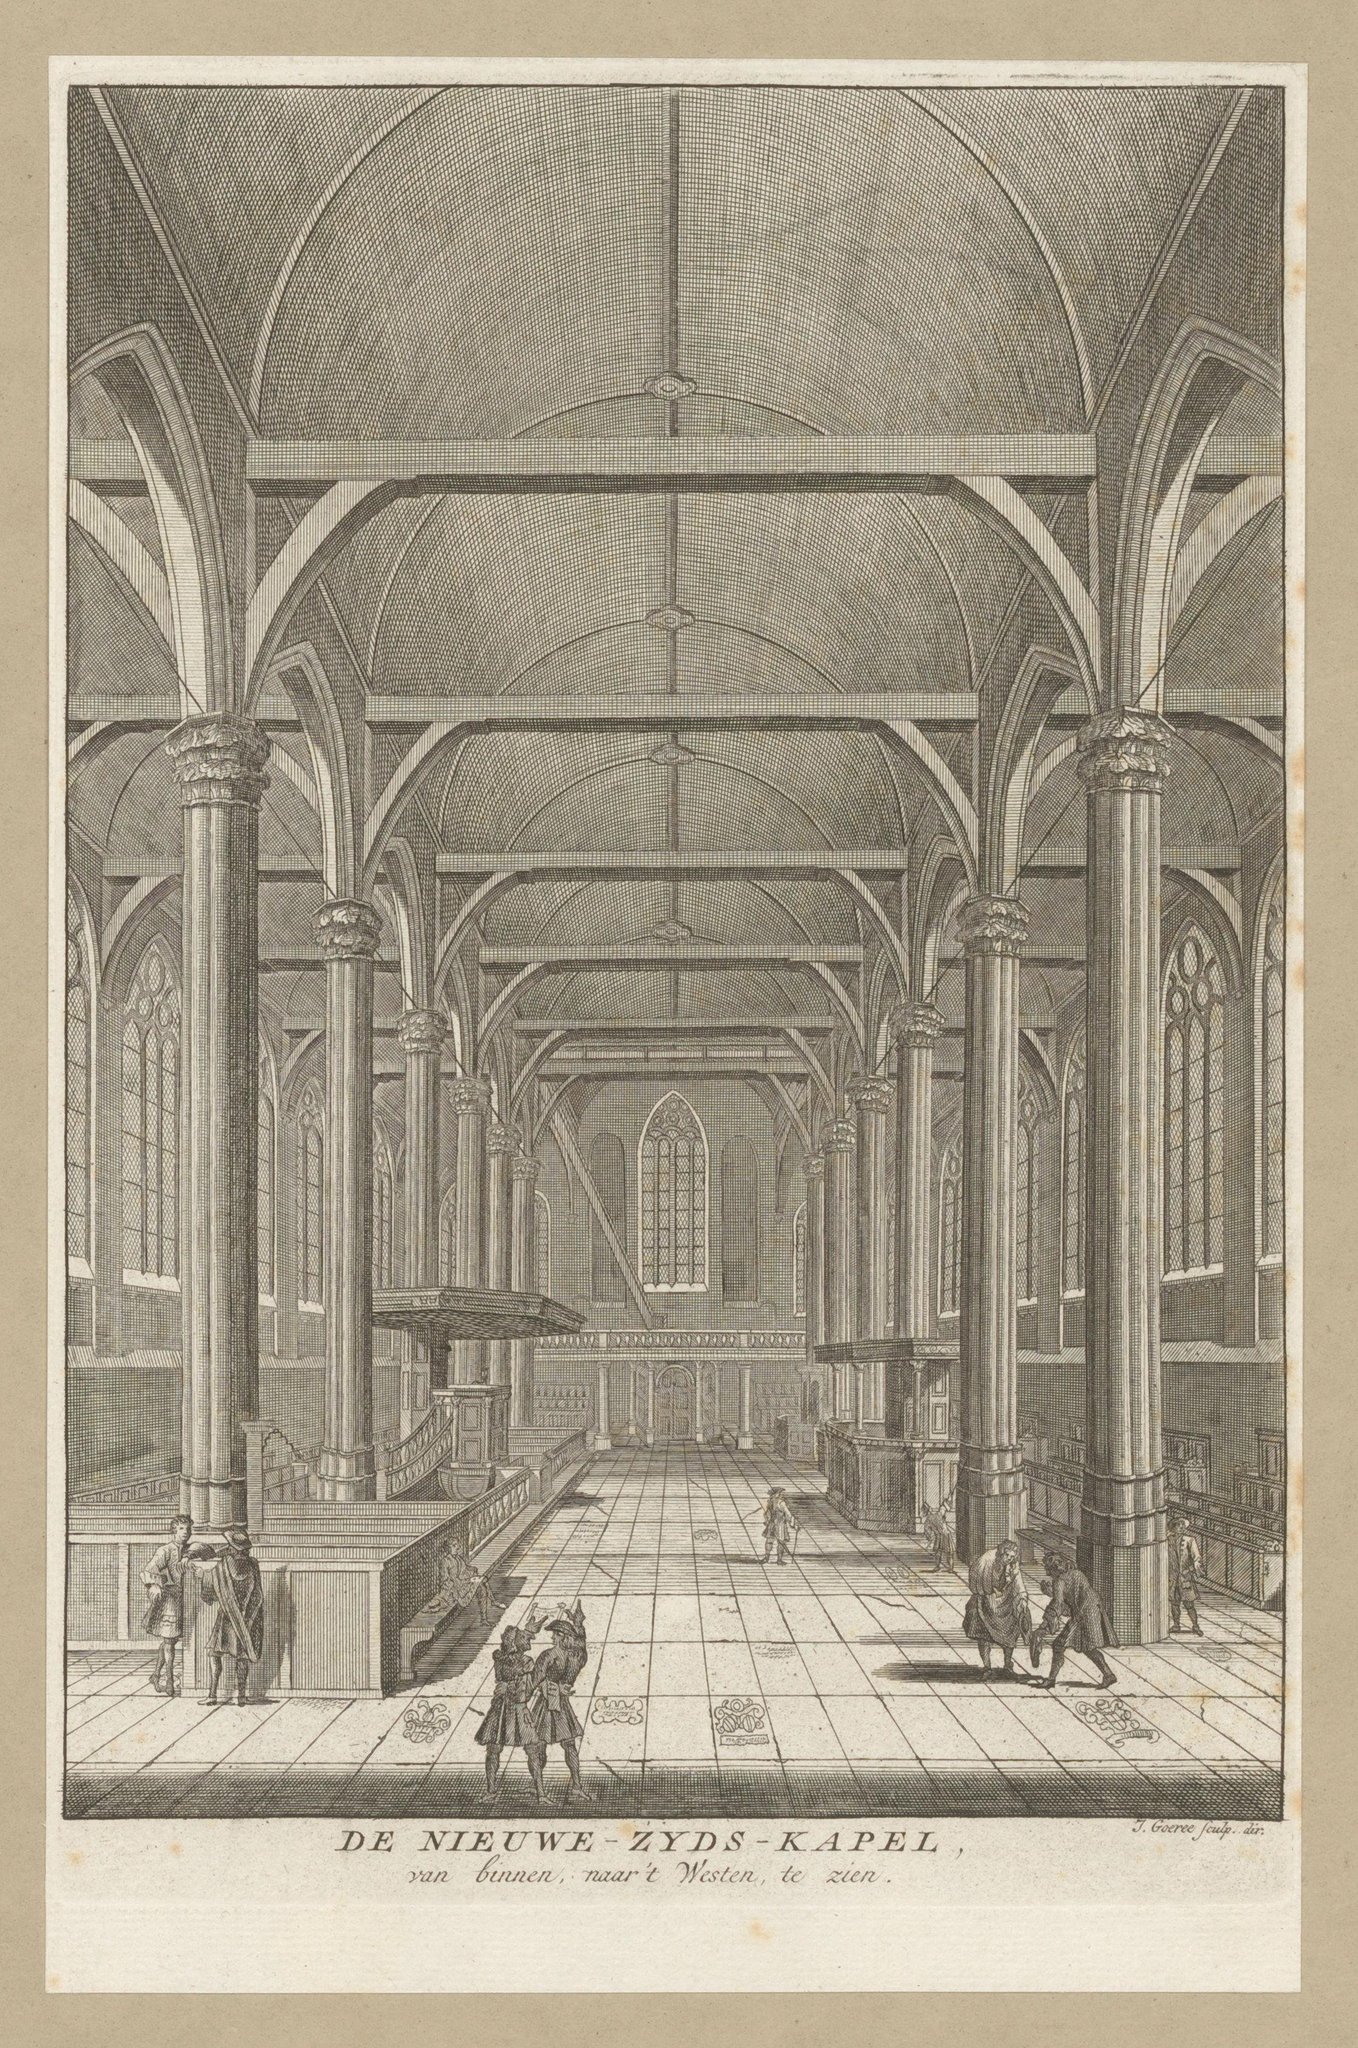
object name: print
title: Interieur van de Nieuwezijds Kapel te Amsterdam, gezien richting het westen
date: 1765-1782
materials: paper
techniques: engraving, etching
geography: amsterdam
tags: interior of church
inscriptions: collector's mark: Lugt 1641b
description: Prent mogelijk uit: Wagenaar, Jan. Amsterdam, in zyne opkomst, aanwas, geschiedenissen (…). Amsterdam: Isaak Tirion, 1765, dl. 2. Of uit: Verzameling der fraaiste gezigten van Amsterdam in negen en zeventig afbeeldingen. Amsterdam en Harlingen: Petrus Conradi en Volkert van der Plaats, 1782.